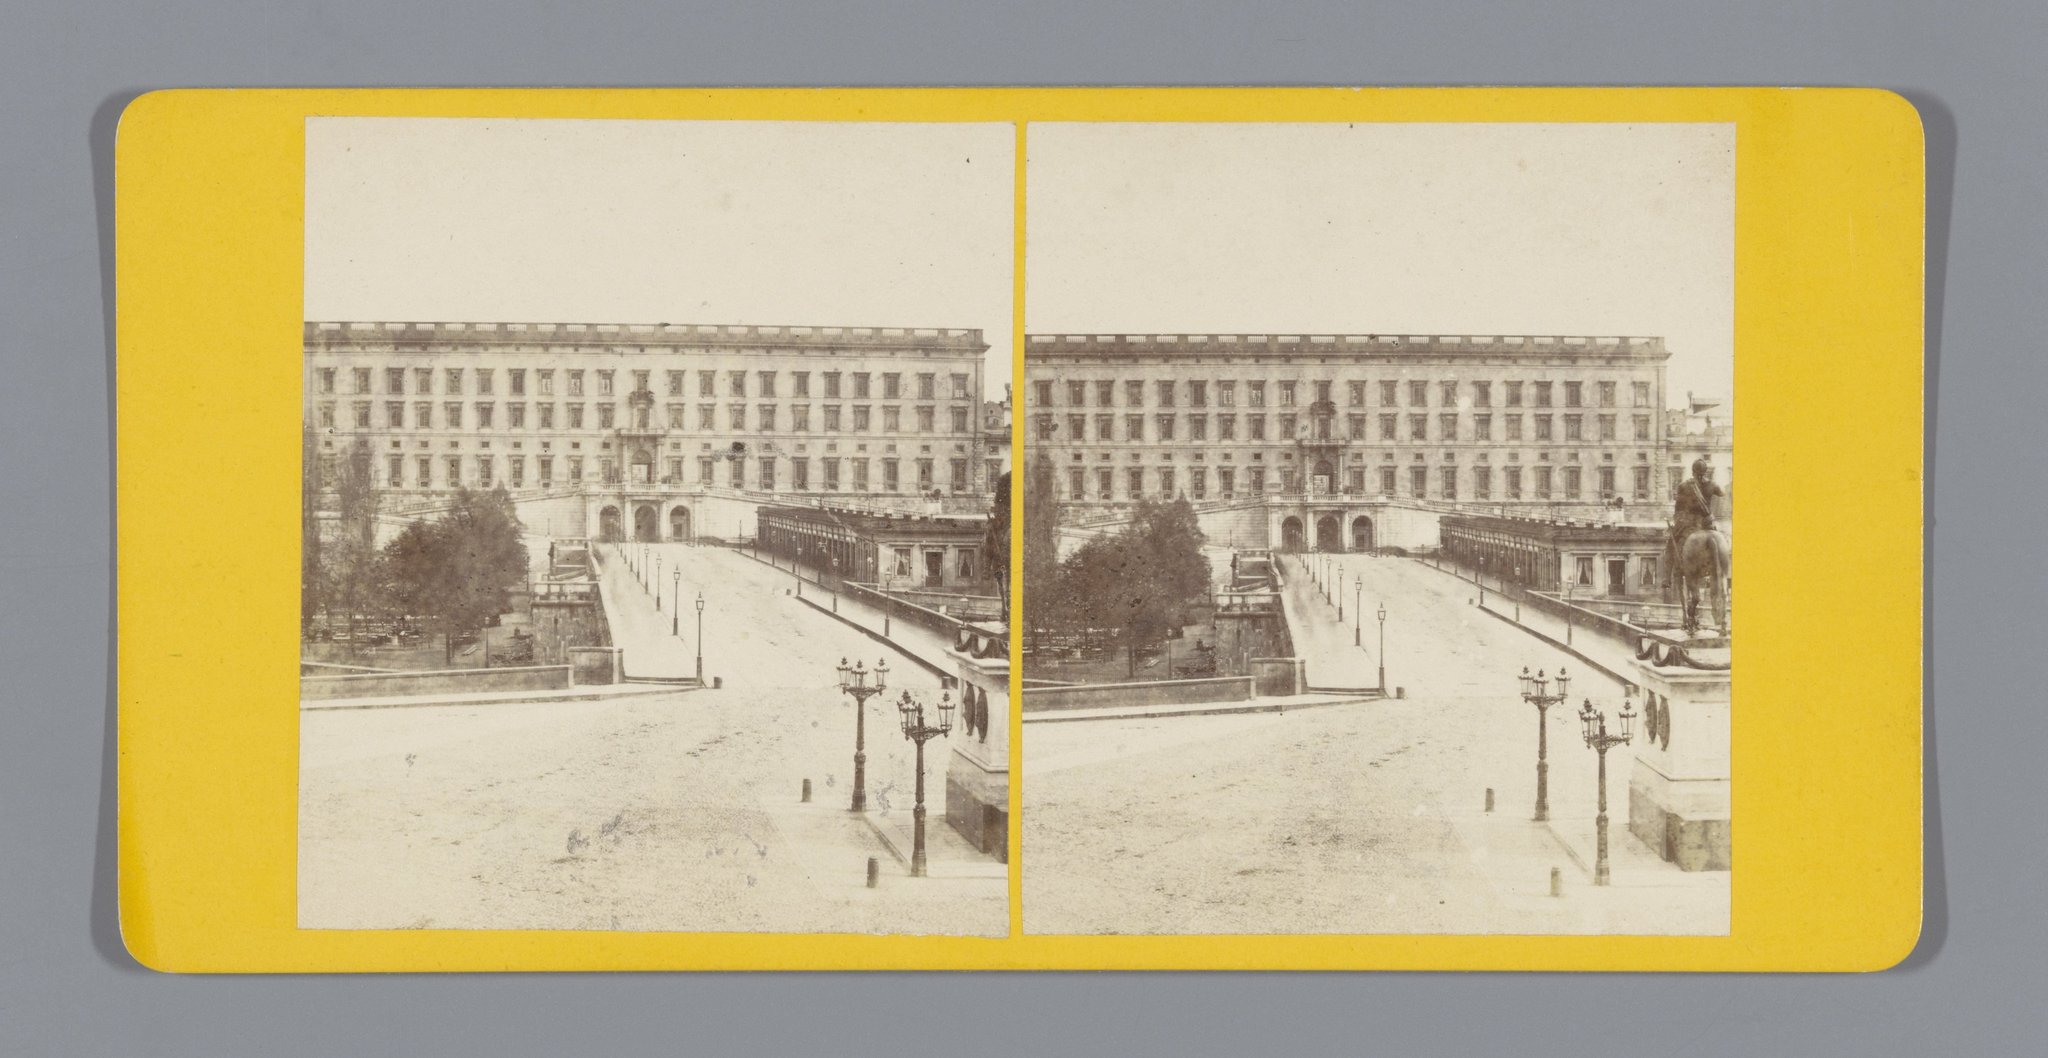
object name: stereograph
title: Stockholm, Kon. Paleis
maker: Anonymous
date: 1868-1890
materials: cardboard, paper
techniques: albumen print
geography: stockholm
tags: palace